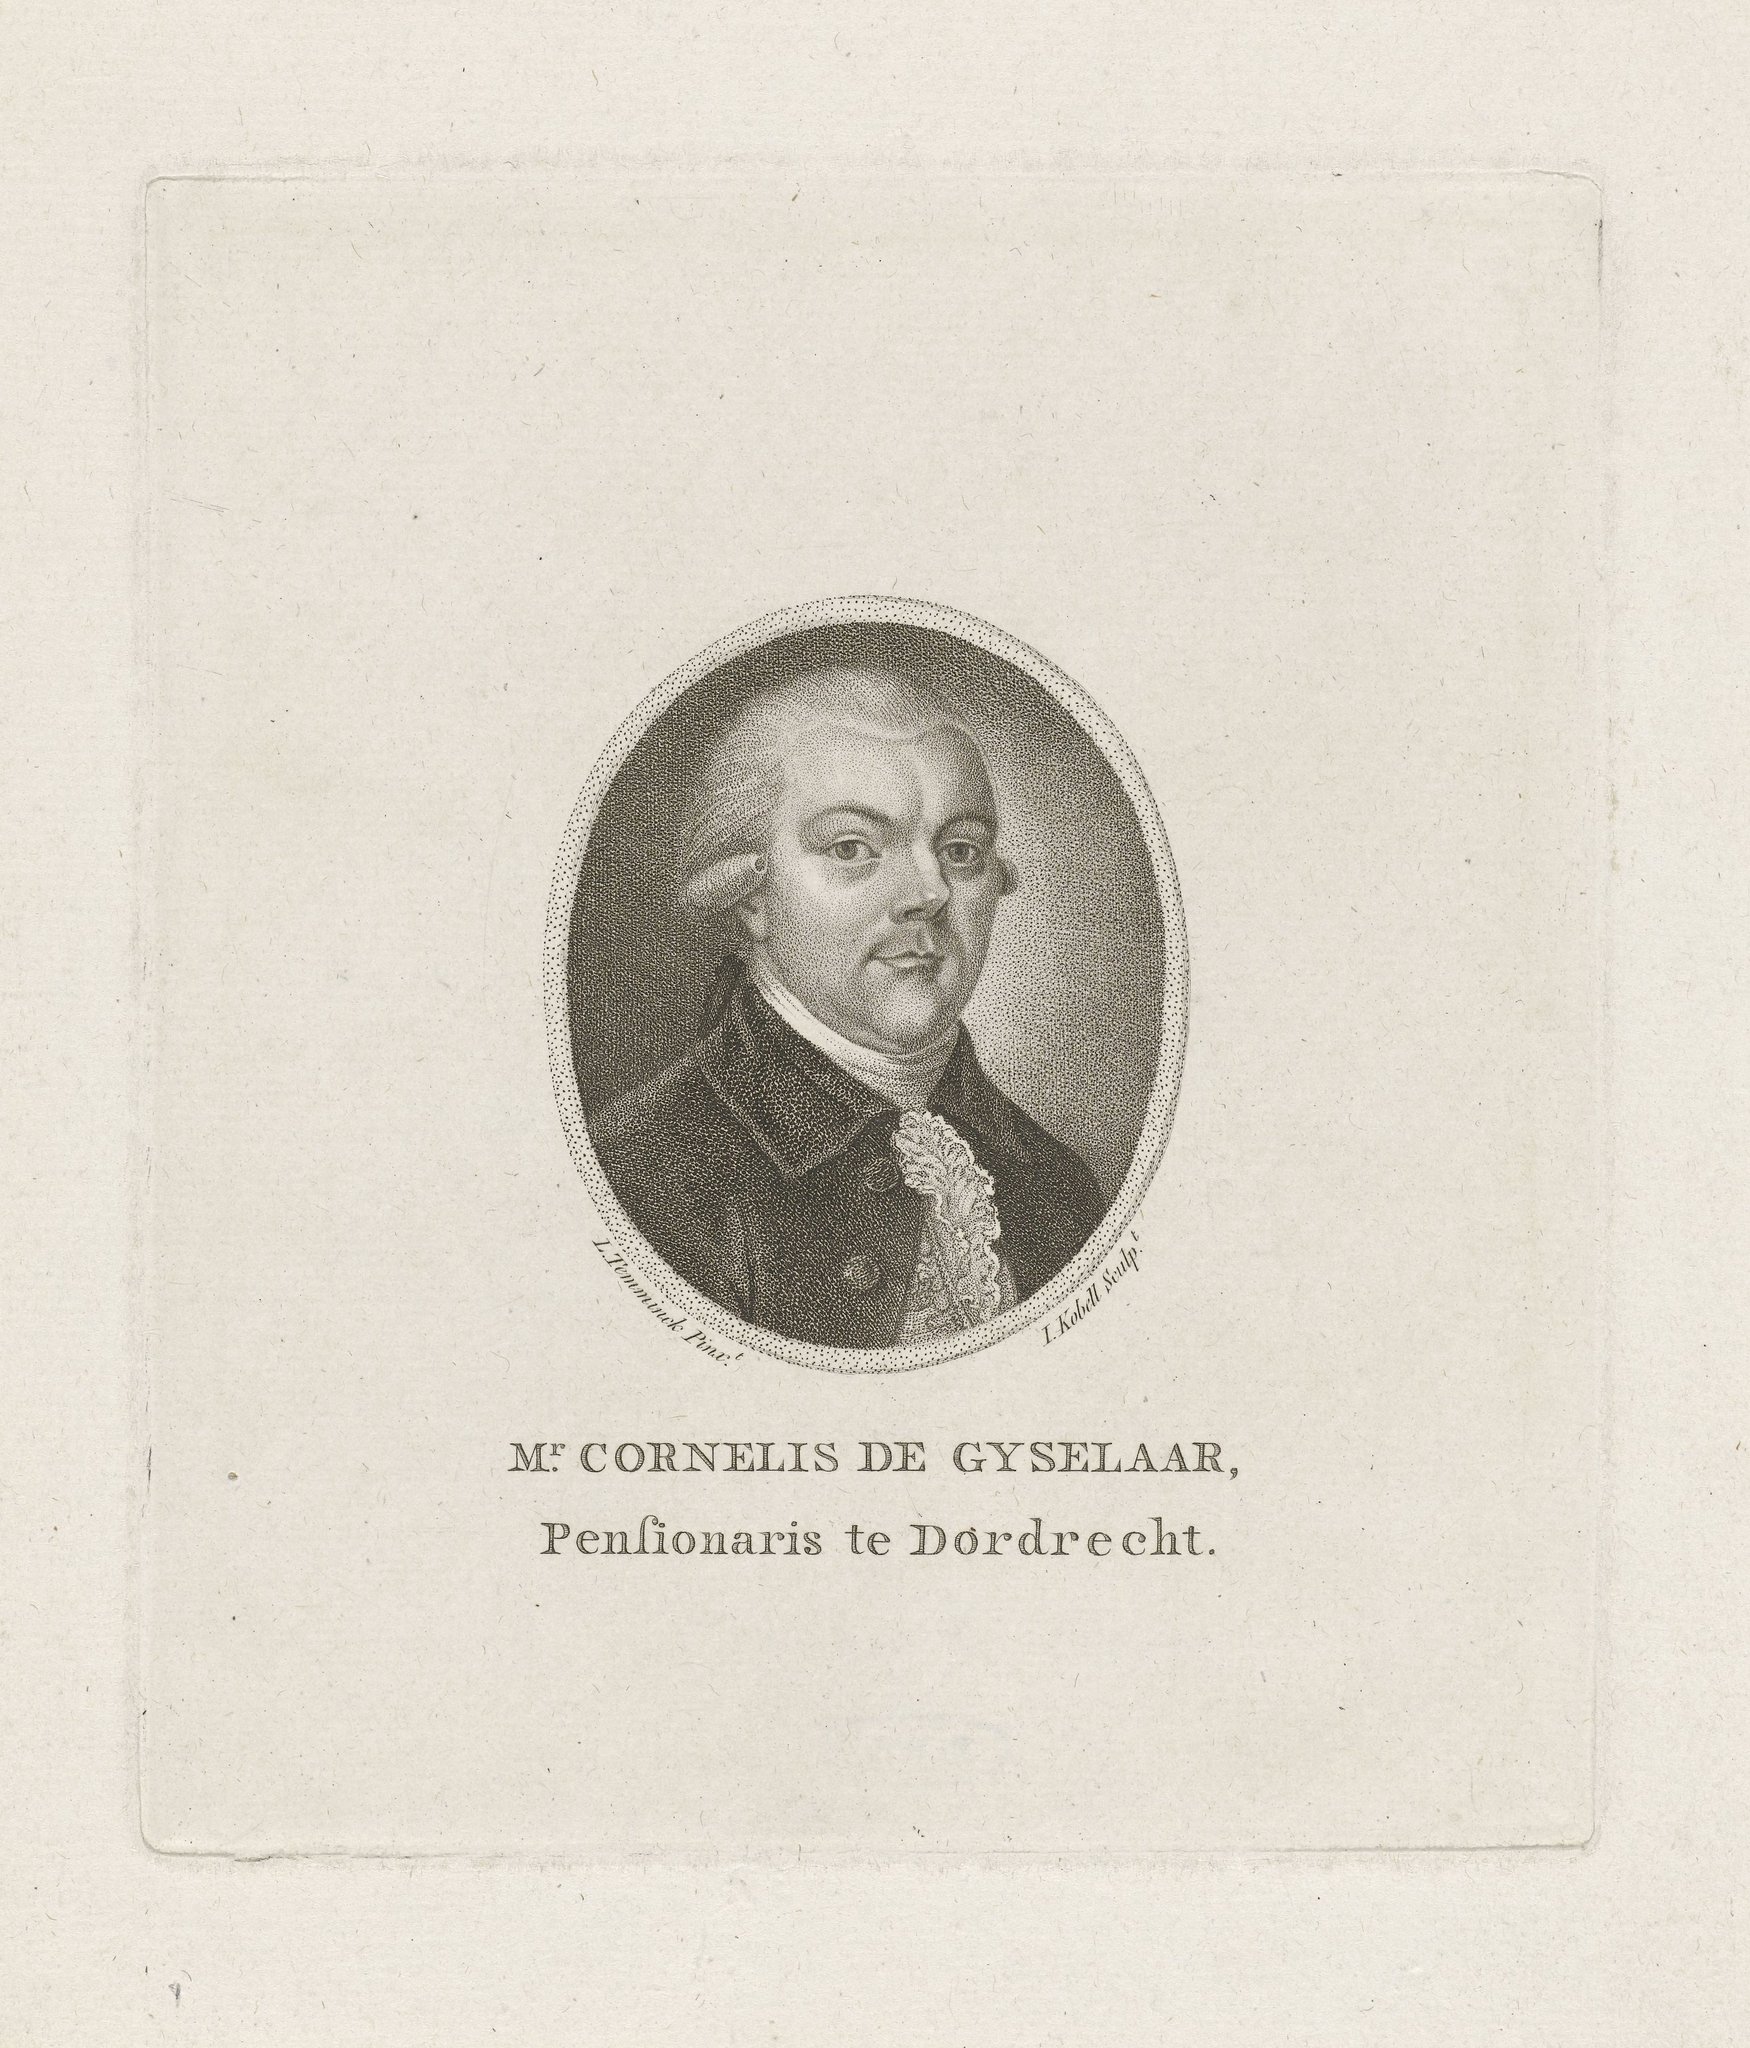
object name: print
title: Mr. Cornelis de Gyselaar, Pensionaris te Dordrecht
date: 1766-1833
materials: paper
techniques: etching, engraving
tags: gorinchem, pensionaris, cornelis de gijselaar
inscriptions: collector's mark: Lugt 2228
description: Portretbuste van Cornelis de Gijselaar, patriot en pensoinaris te Dordrecht.